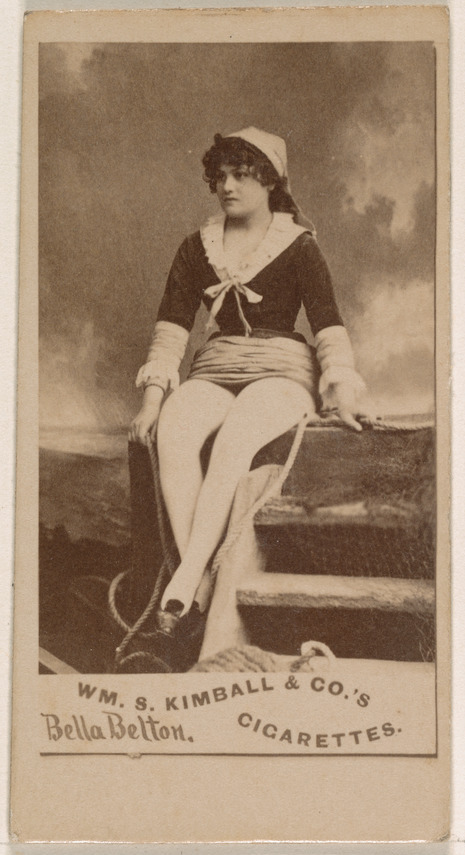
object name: photograph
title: Bella Betton, from the Actresses series (N203) issued by Wm. S. Kimball & Co.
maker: william s. kimball & company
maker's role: publisher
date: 1889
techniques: color lithograph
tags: portraits,women,actresses